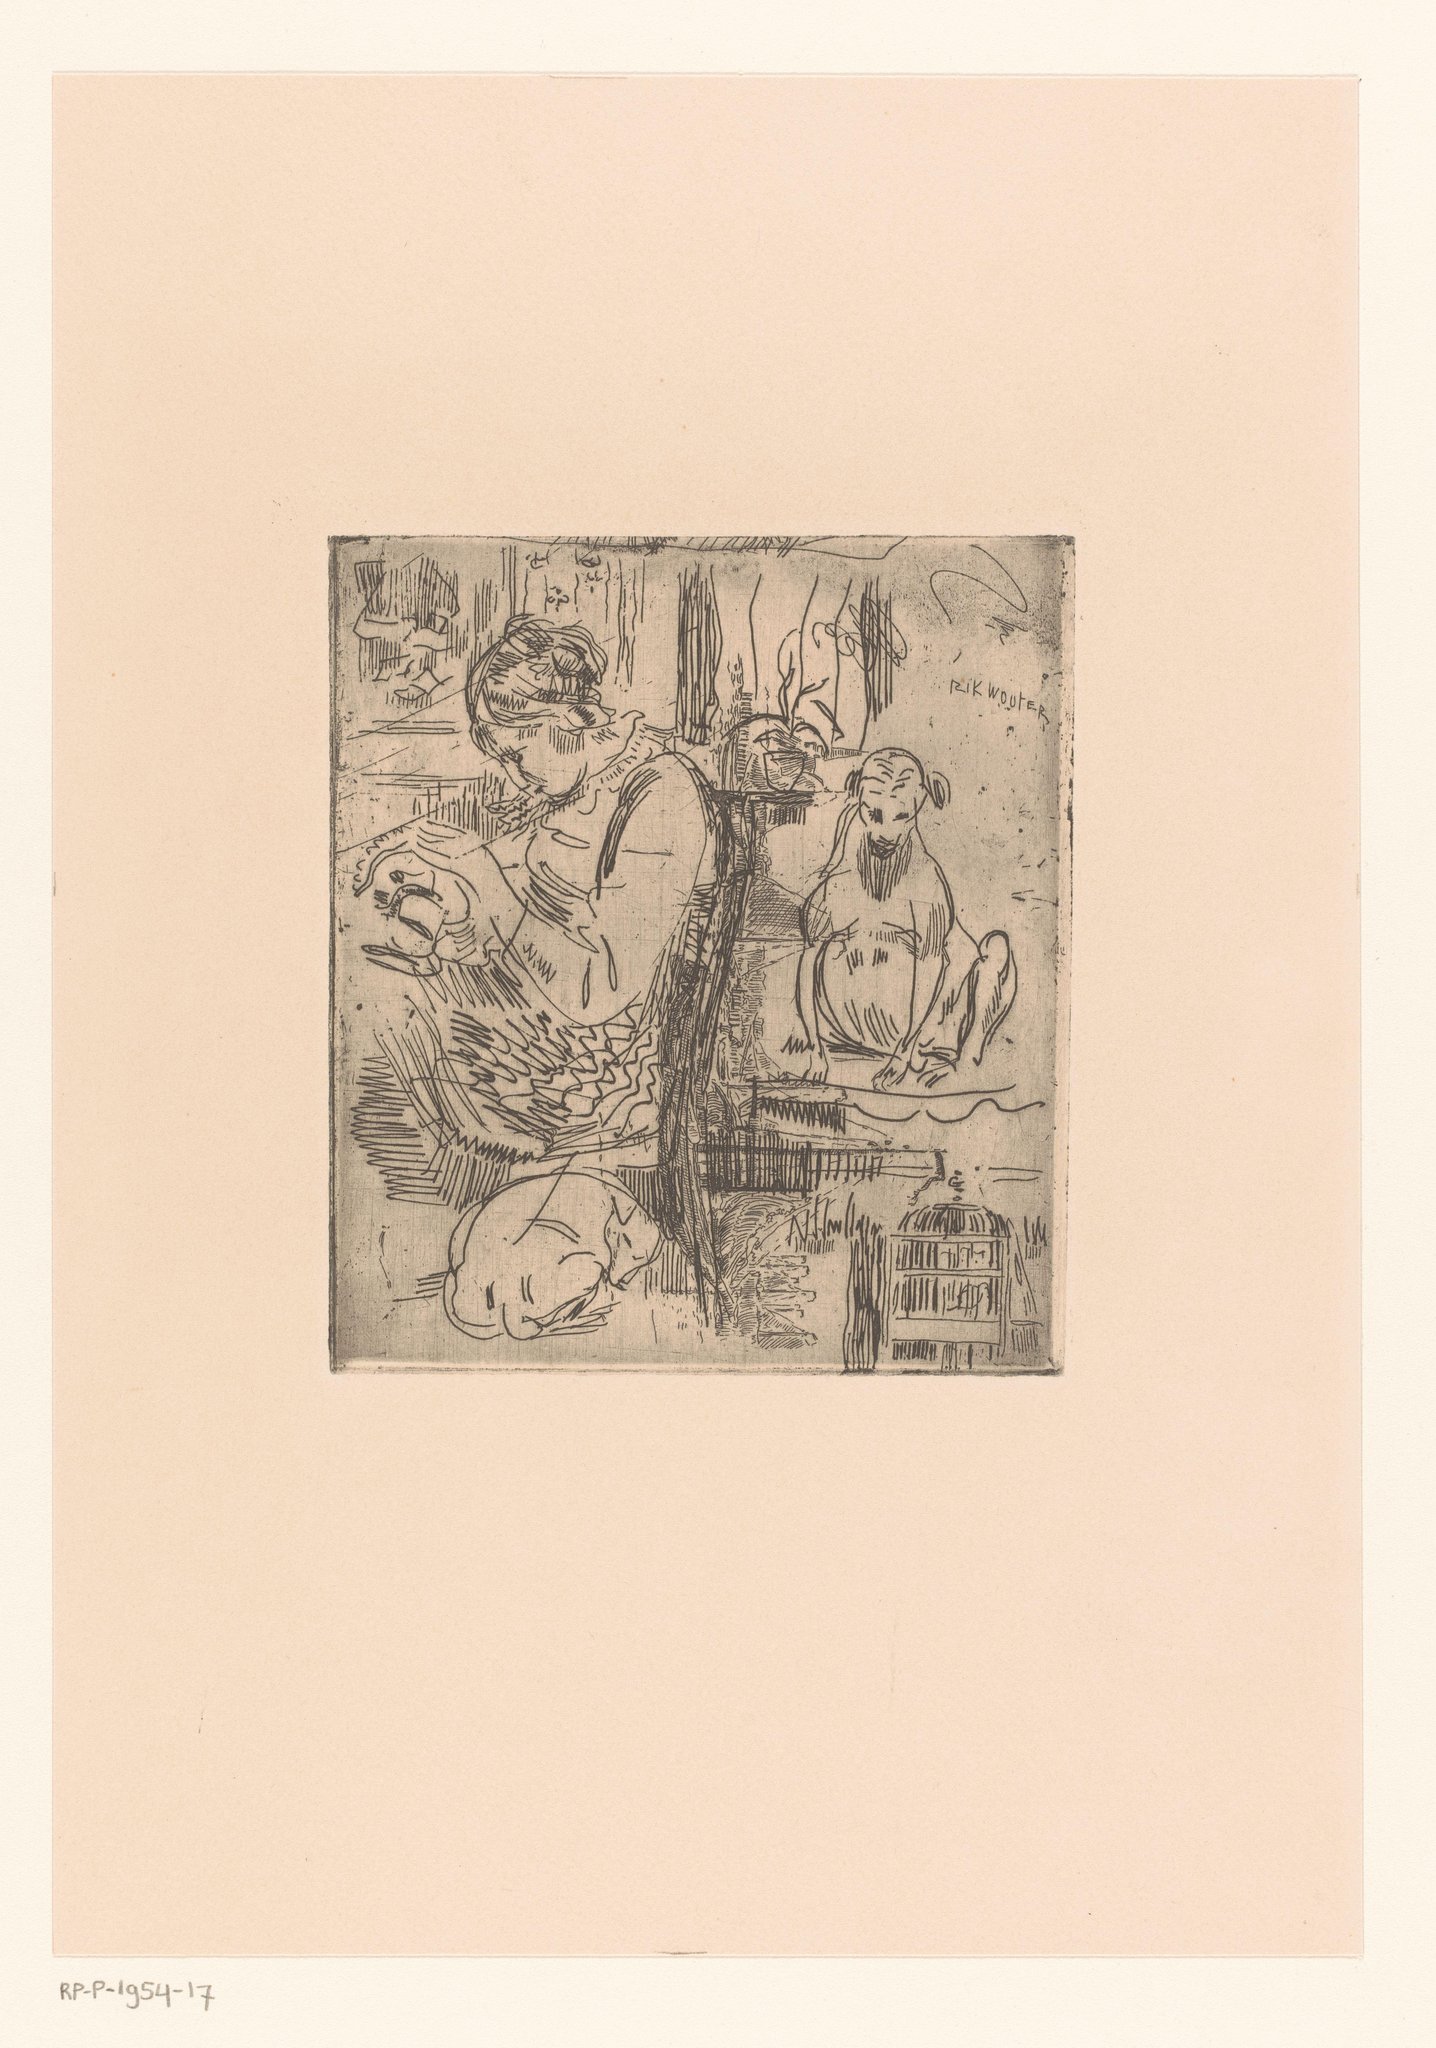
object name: print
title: Zittende vrouw, hond en een haven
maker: rik wouters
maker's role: draughtsman, print maker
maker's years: 1882-1916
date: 1892-1916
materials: paper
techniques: etching, intaglio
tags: nel wouters, harbour, historical persons - bb - woman, dog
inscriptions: collector's mark: Lugt 2228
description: Blad met verschillende schetsen over elkaar heen, waaronder een haven, Nel aan het handwerken en de hond Stella.